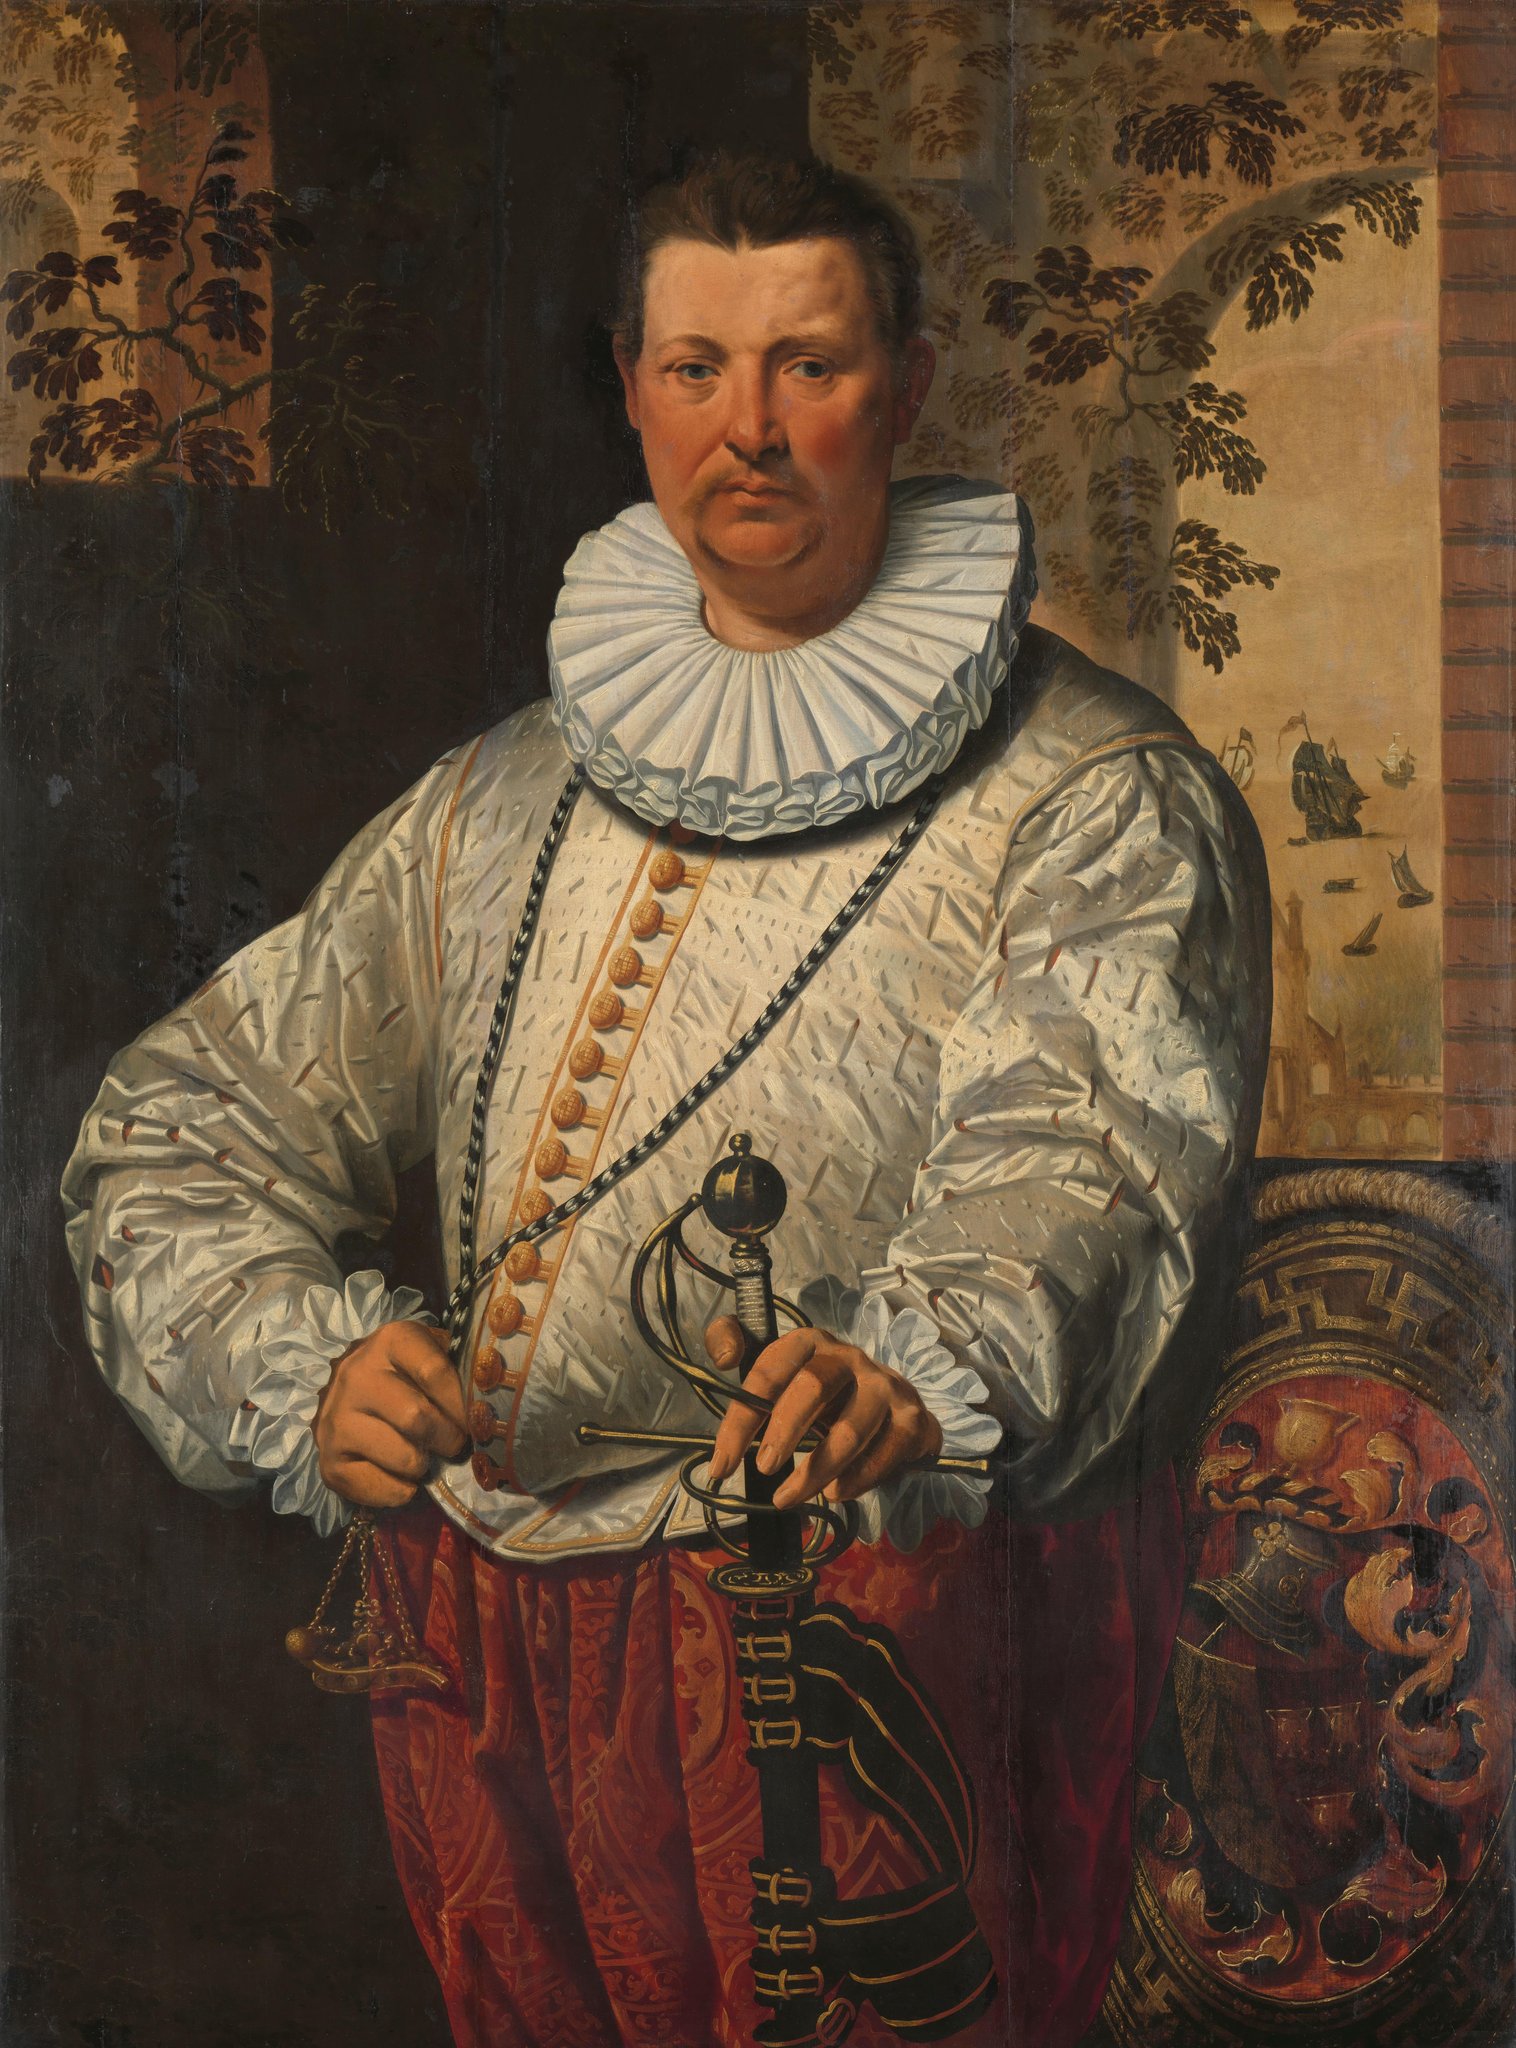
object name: painting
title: Portrait of a Dutch Admiral of the Fleet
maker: pieter pietersz. (i)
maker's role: painter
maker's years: 1540-1603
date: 1570-1610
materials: oil, panel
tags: ranks in the navy, hacking and thrusting weapons: sword, historical persons not known by name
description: Portret van een Hollandse vlootvoogd. Kniestuk, staande voor een met klimop begroeide muur waarin een venster met uitzicht op zee met schepen. De linkerhand op een sabel, in de rechterhand de ketting waaraan een sifflet of bootsmansfluit hangt. Rechtsonder het familiewapen.